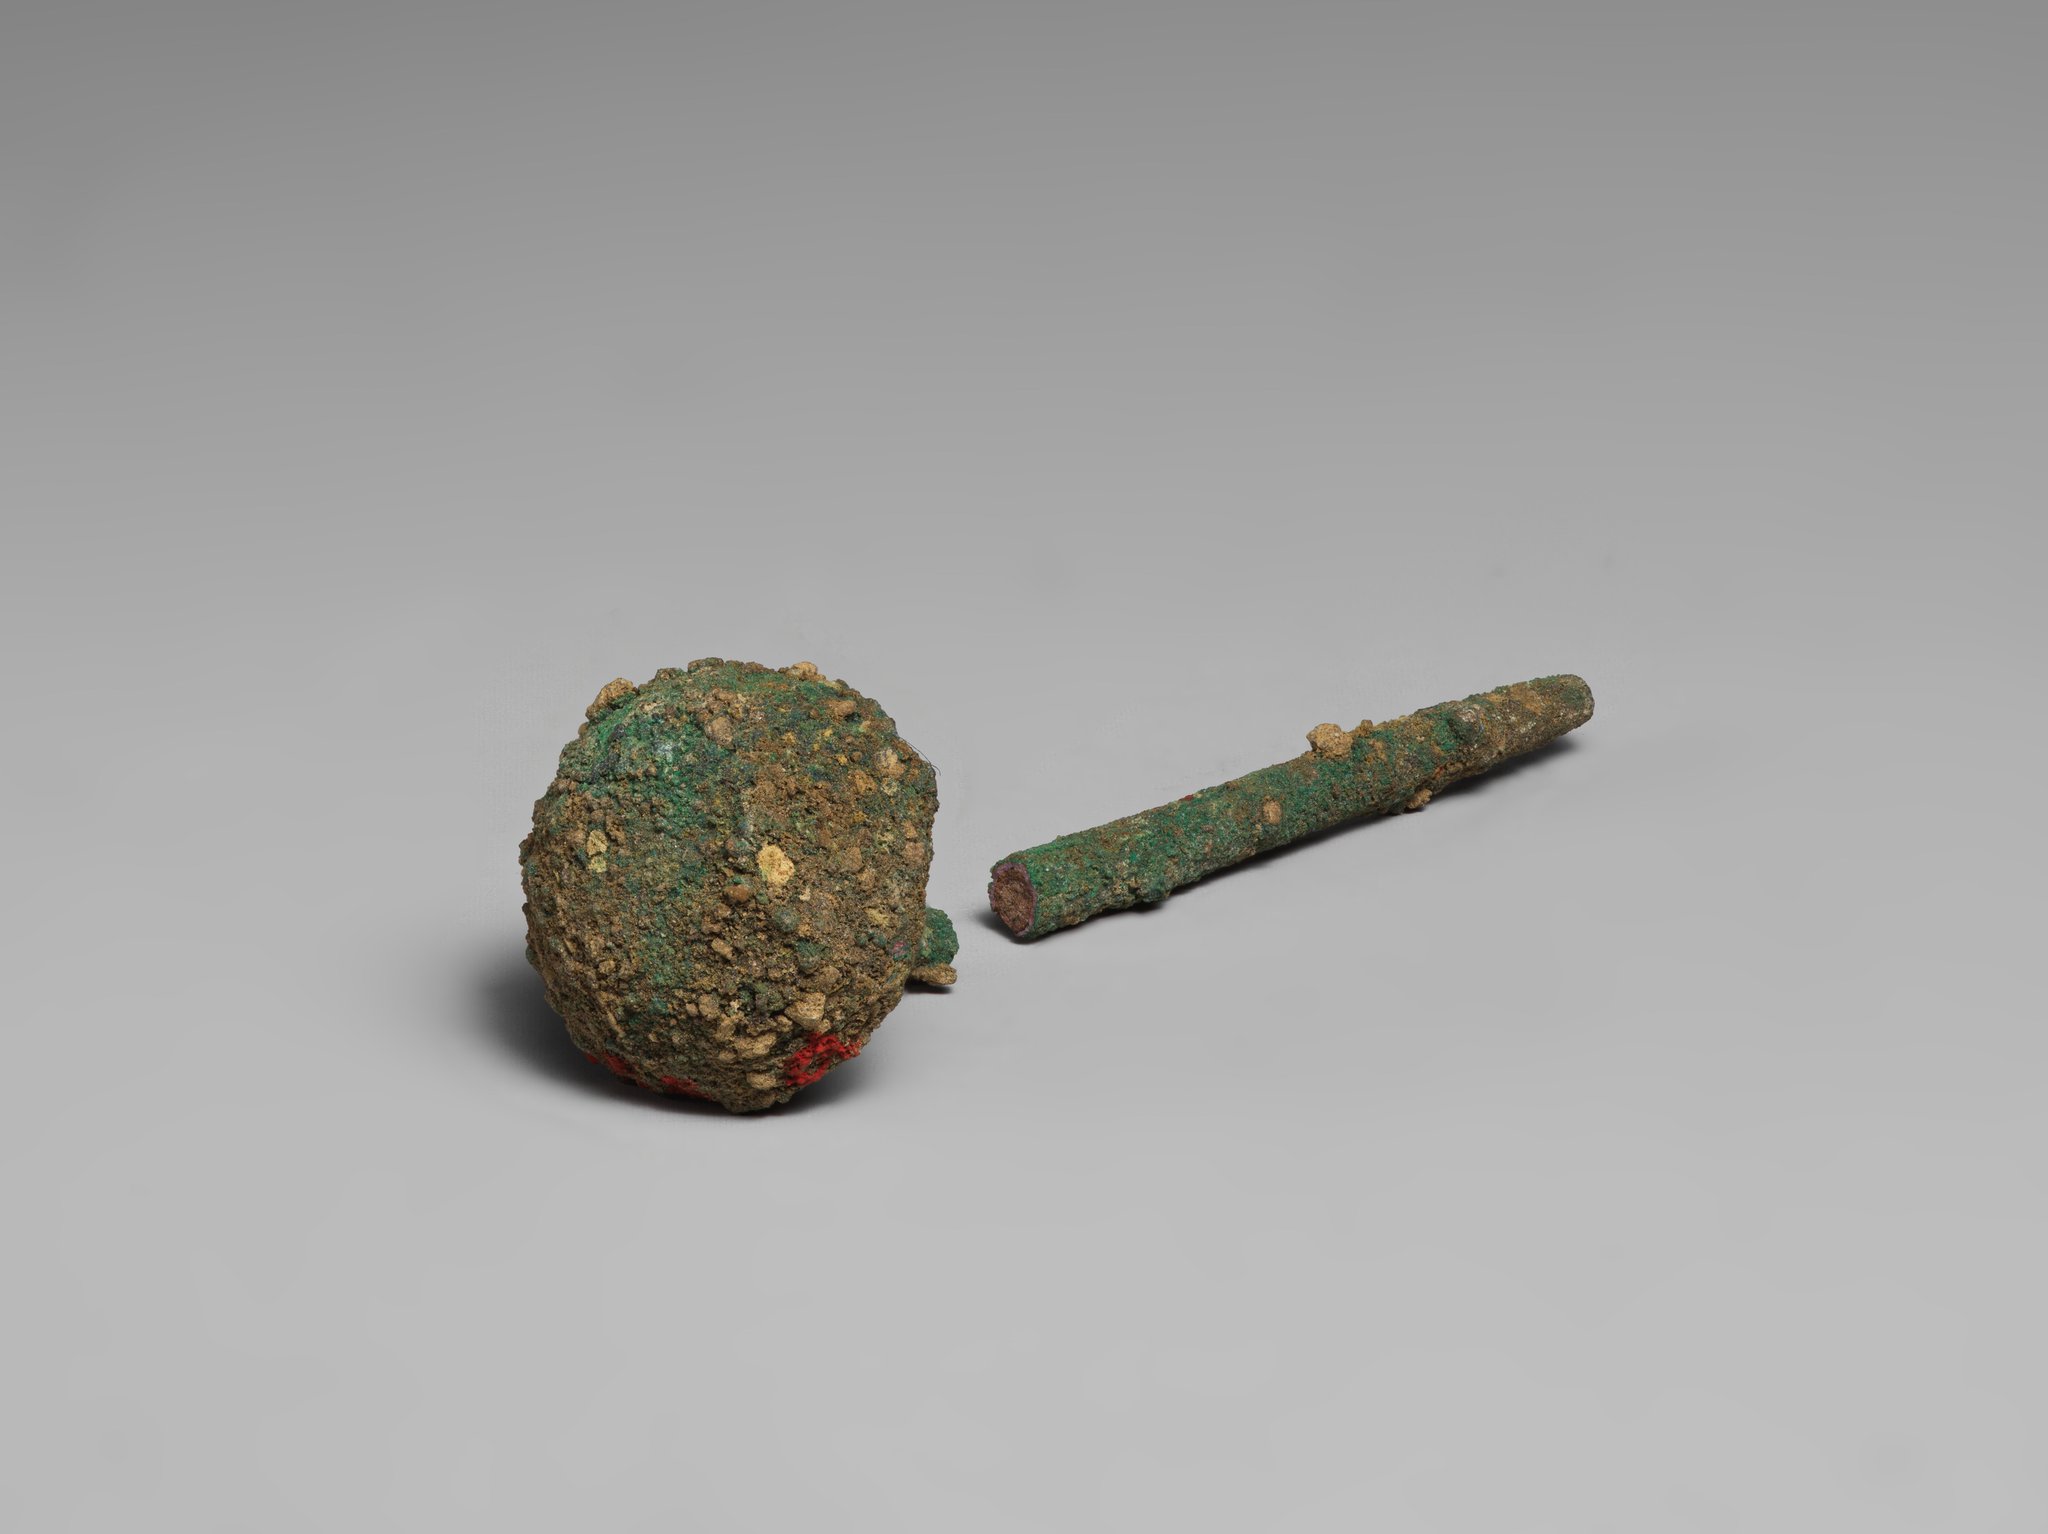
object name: stud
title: Studs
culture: iranian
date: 900-801 BCE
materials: bronze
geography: iran